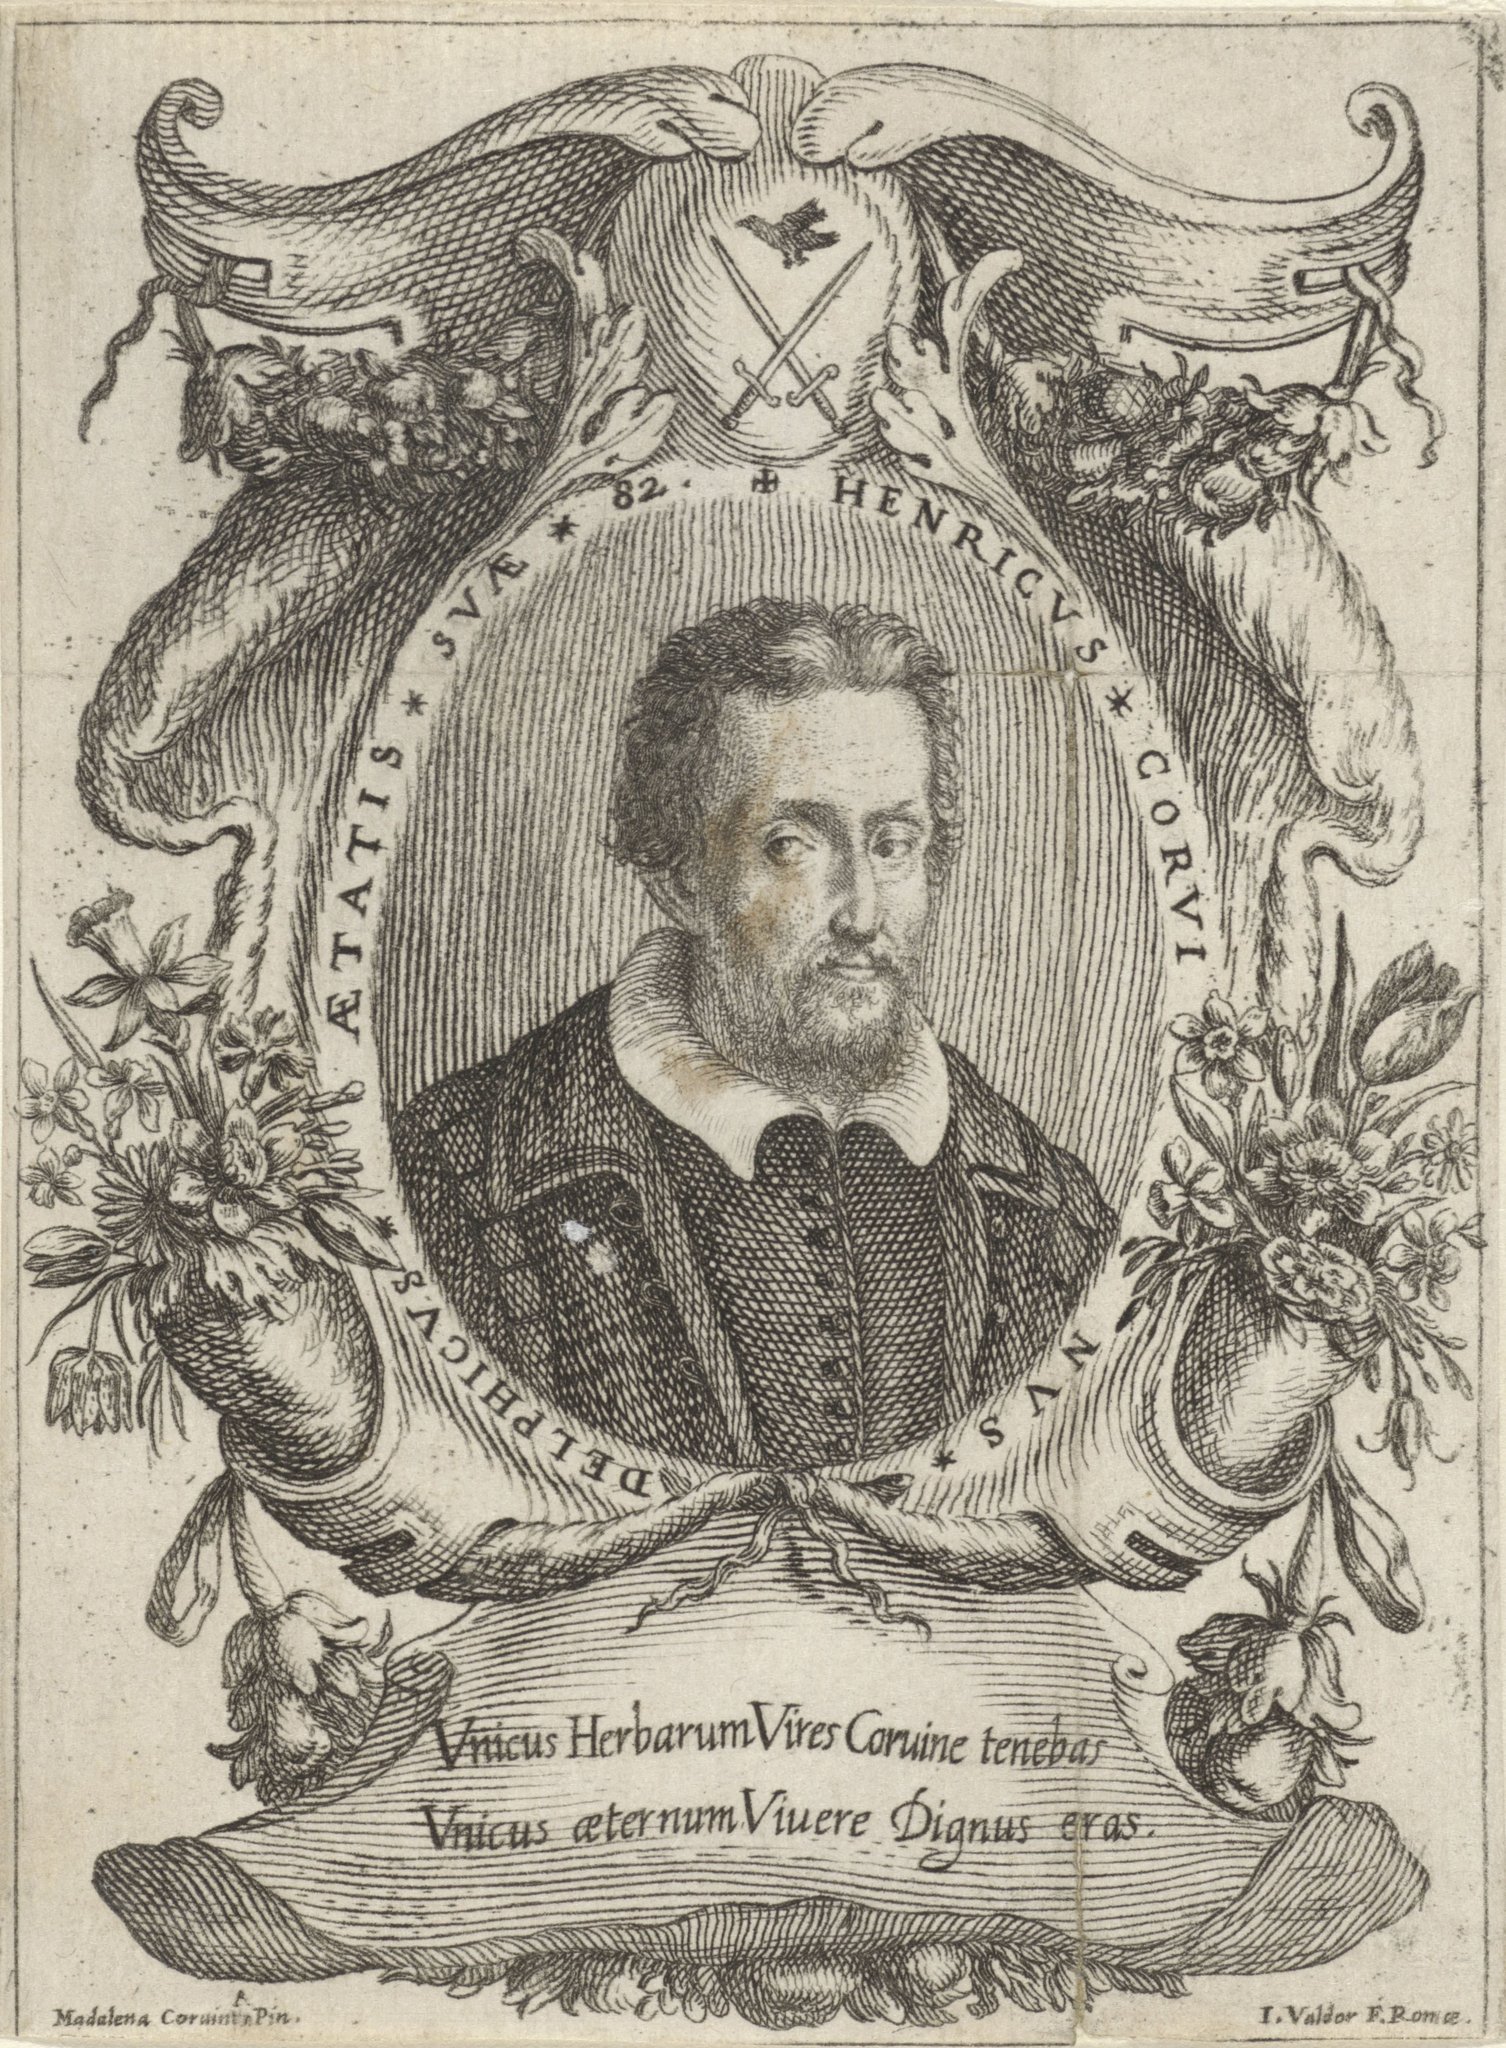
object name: print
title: Portret van Henricus Corvinus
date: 1626-1670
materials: paper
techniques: etching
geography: rome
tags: henricus corvinius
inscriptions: collector's mark: Lugt 2228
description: Portret van de in Delft geboren apotheker Henricus Corvinus, rond wie in Rome zich een culturele kring had gevormd, op 82-jarige leeftijd